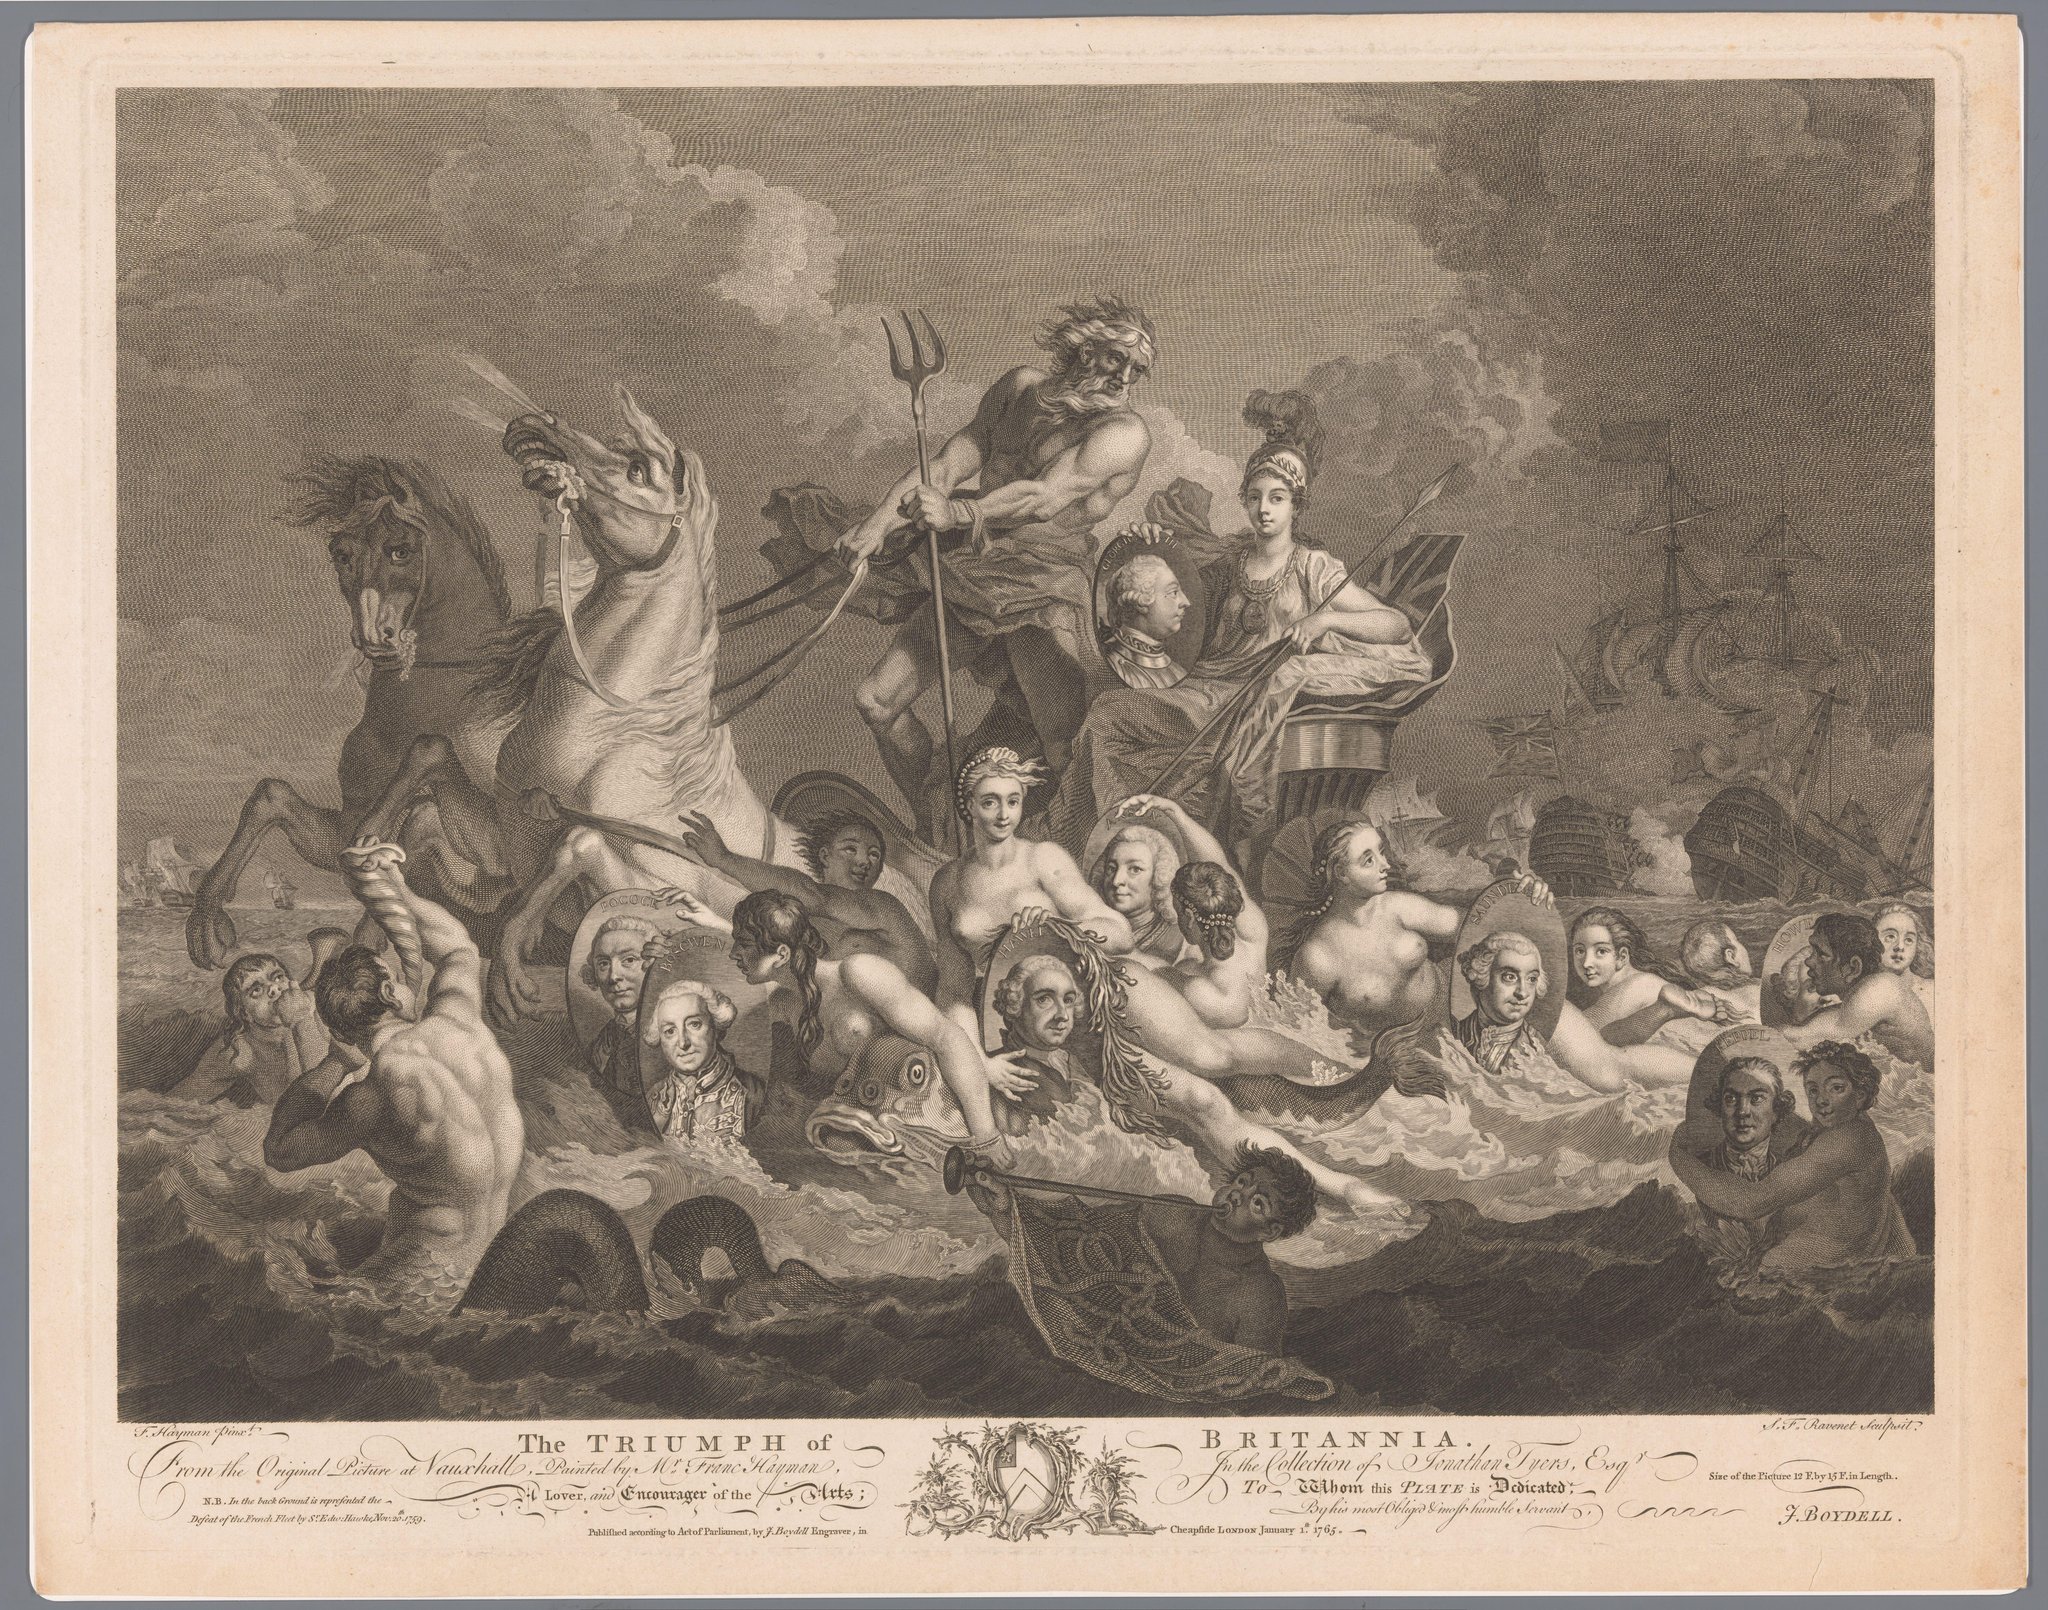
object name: print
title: The Triumph of Britannia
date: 1759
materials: paper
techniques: engraving, etching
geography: london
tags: navy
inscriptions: collector's mark: Lugt 2228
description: Zeegezicht met Neptunus en Britannia op een praalwagen omringd door nimfen en zeemeerminnen die portretten dragen van mariniers.